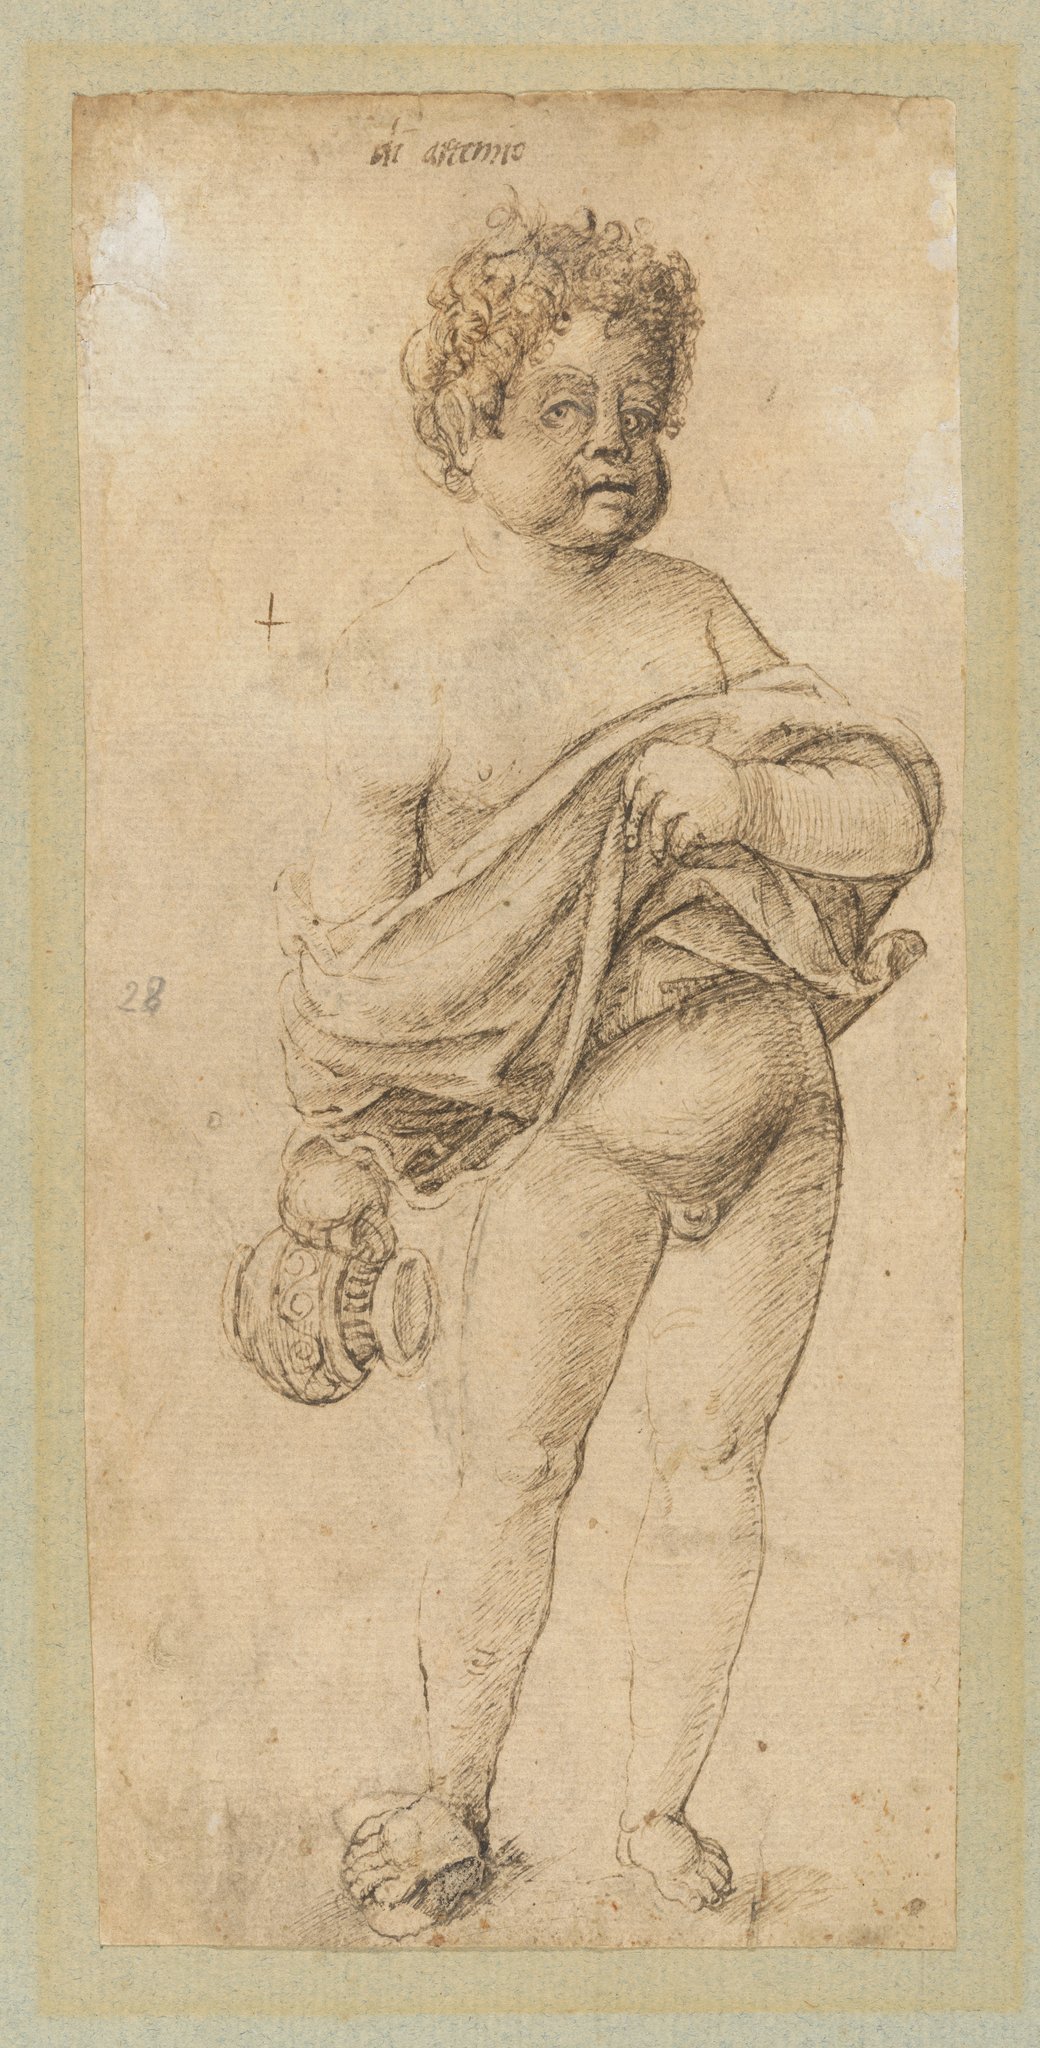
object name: drawing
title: Putto holding a ceramic jug and exposing his genitals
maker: master artemio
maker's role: artist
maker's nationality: italian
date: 1467-1500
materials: chalk, ink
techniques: pen, drawing